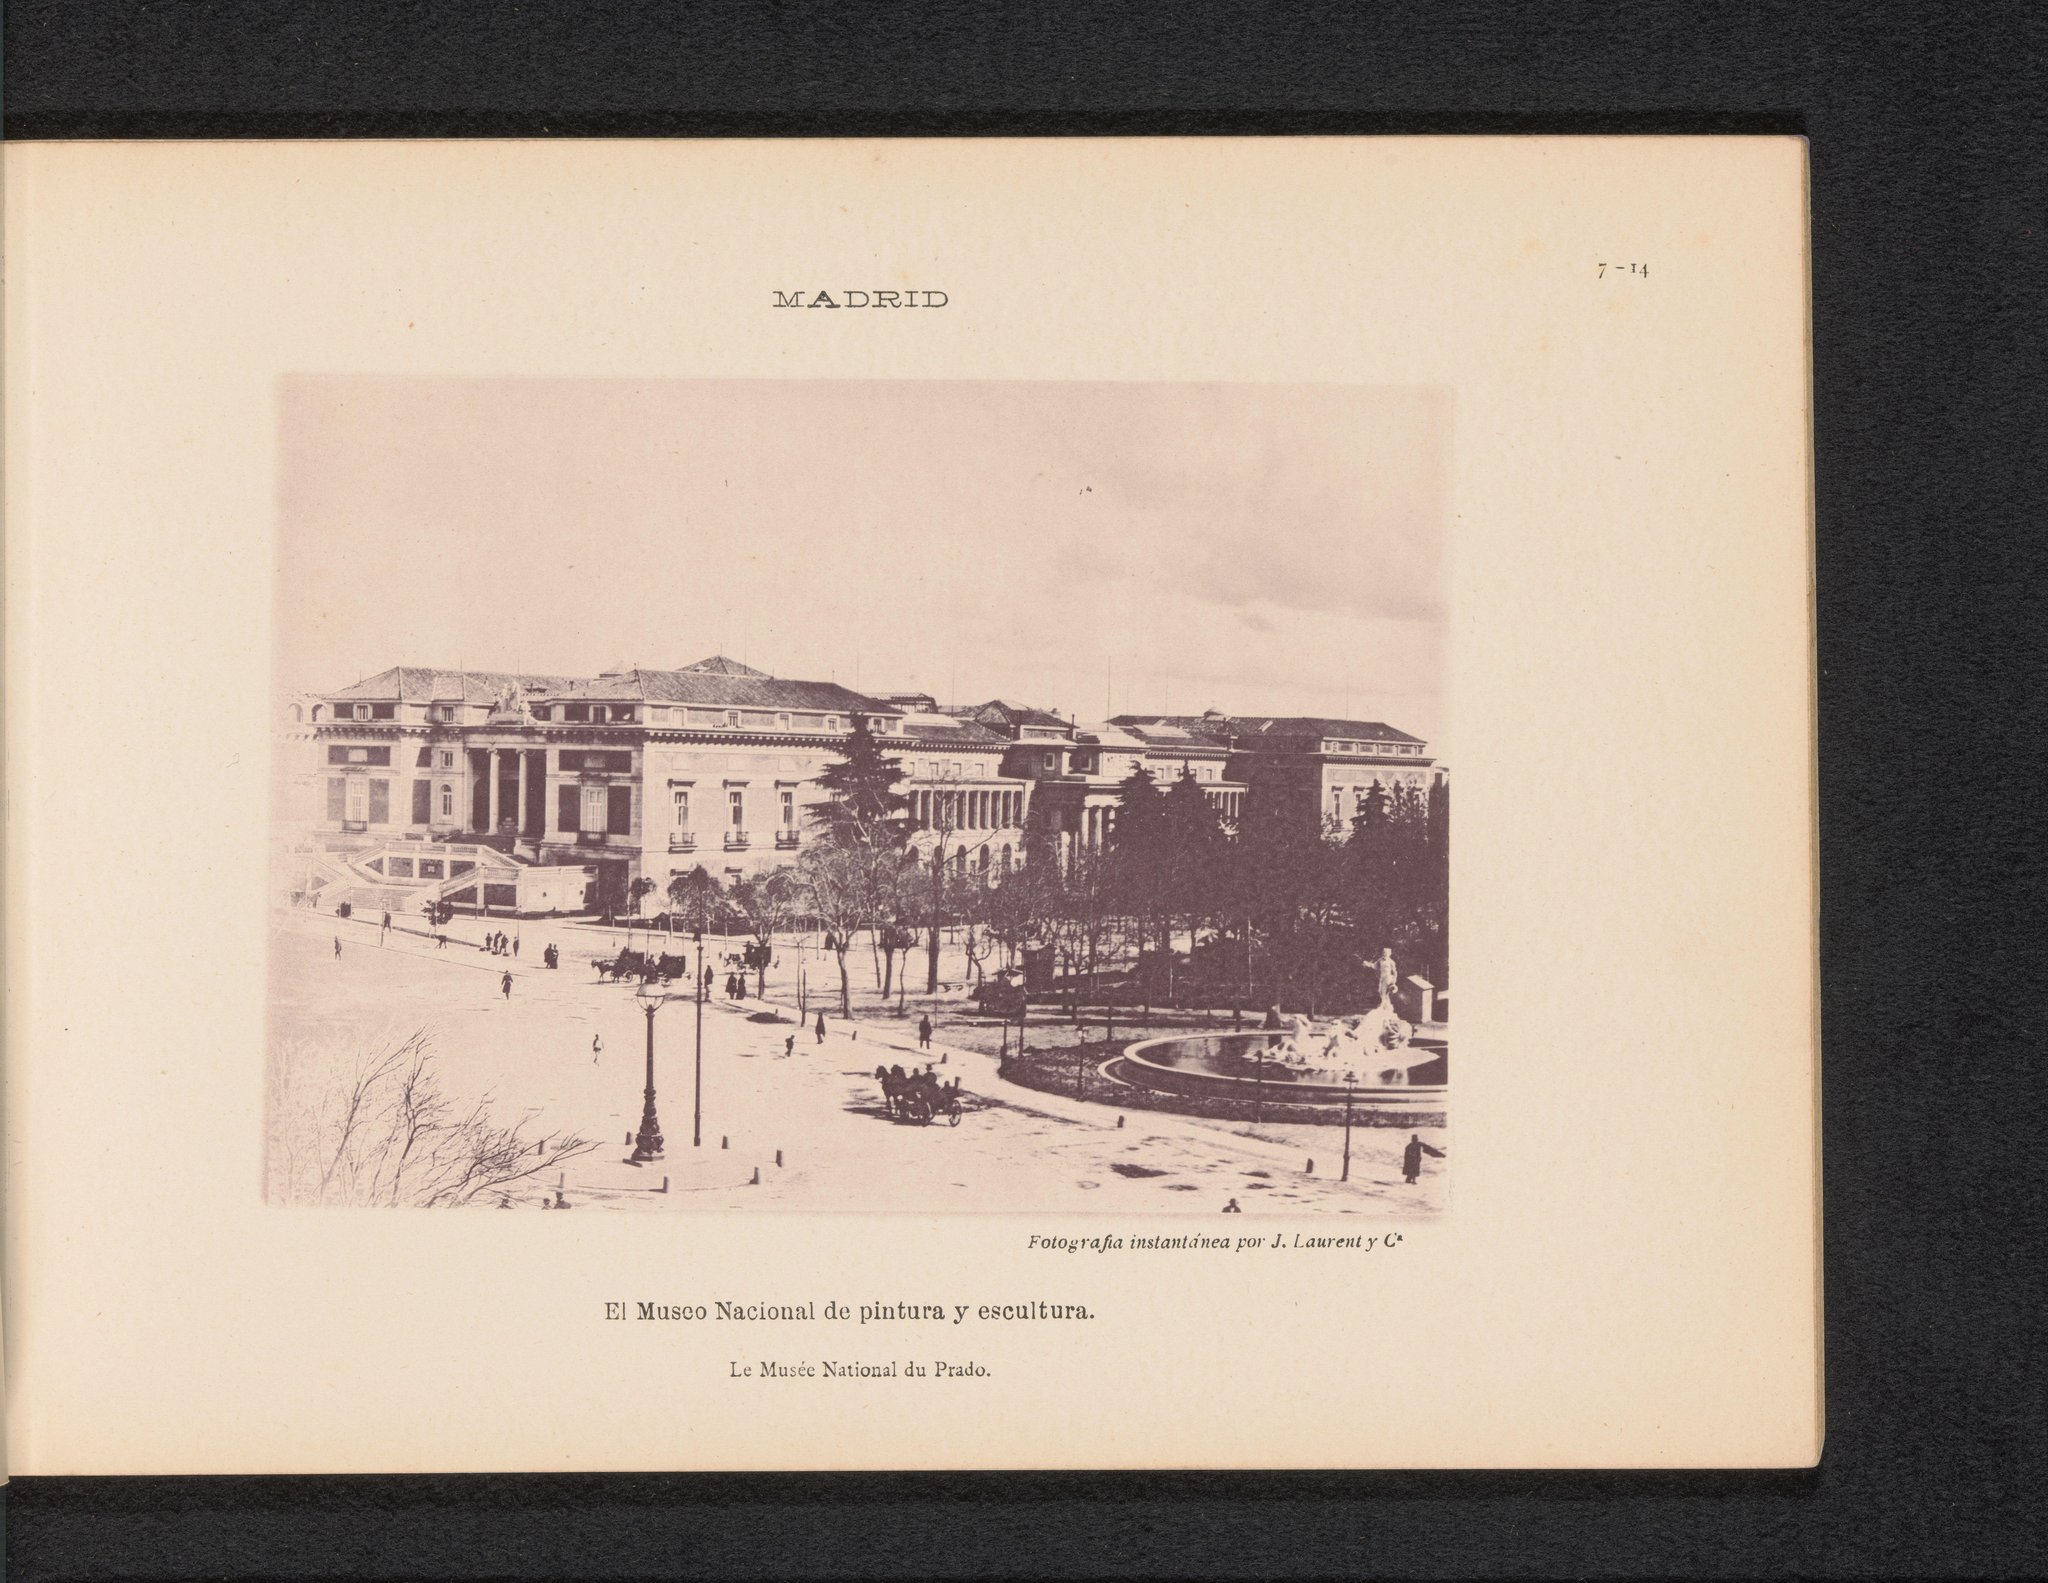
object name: page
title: El Museo Nacional de pintura y escultura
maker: juan laurent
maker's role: publisher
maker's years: 1816-1896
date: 1880-1890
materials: paper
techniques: photograph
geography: madrid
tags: permanent exhibition, museum, ornamental fountain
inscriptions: number: ‘7-14’